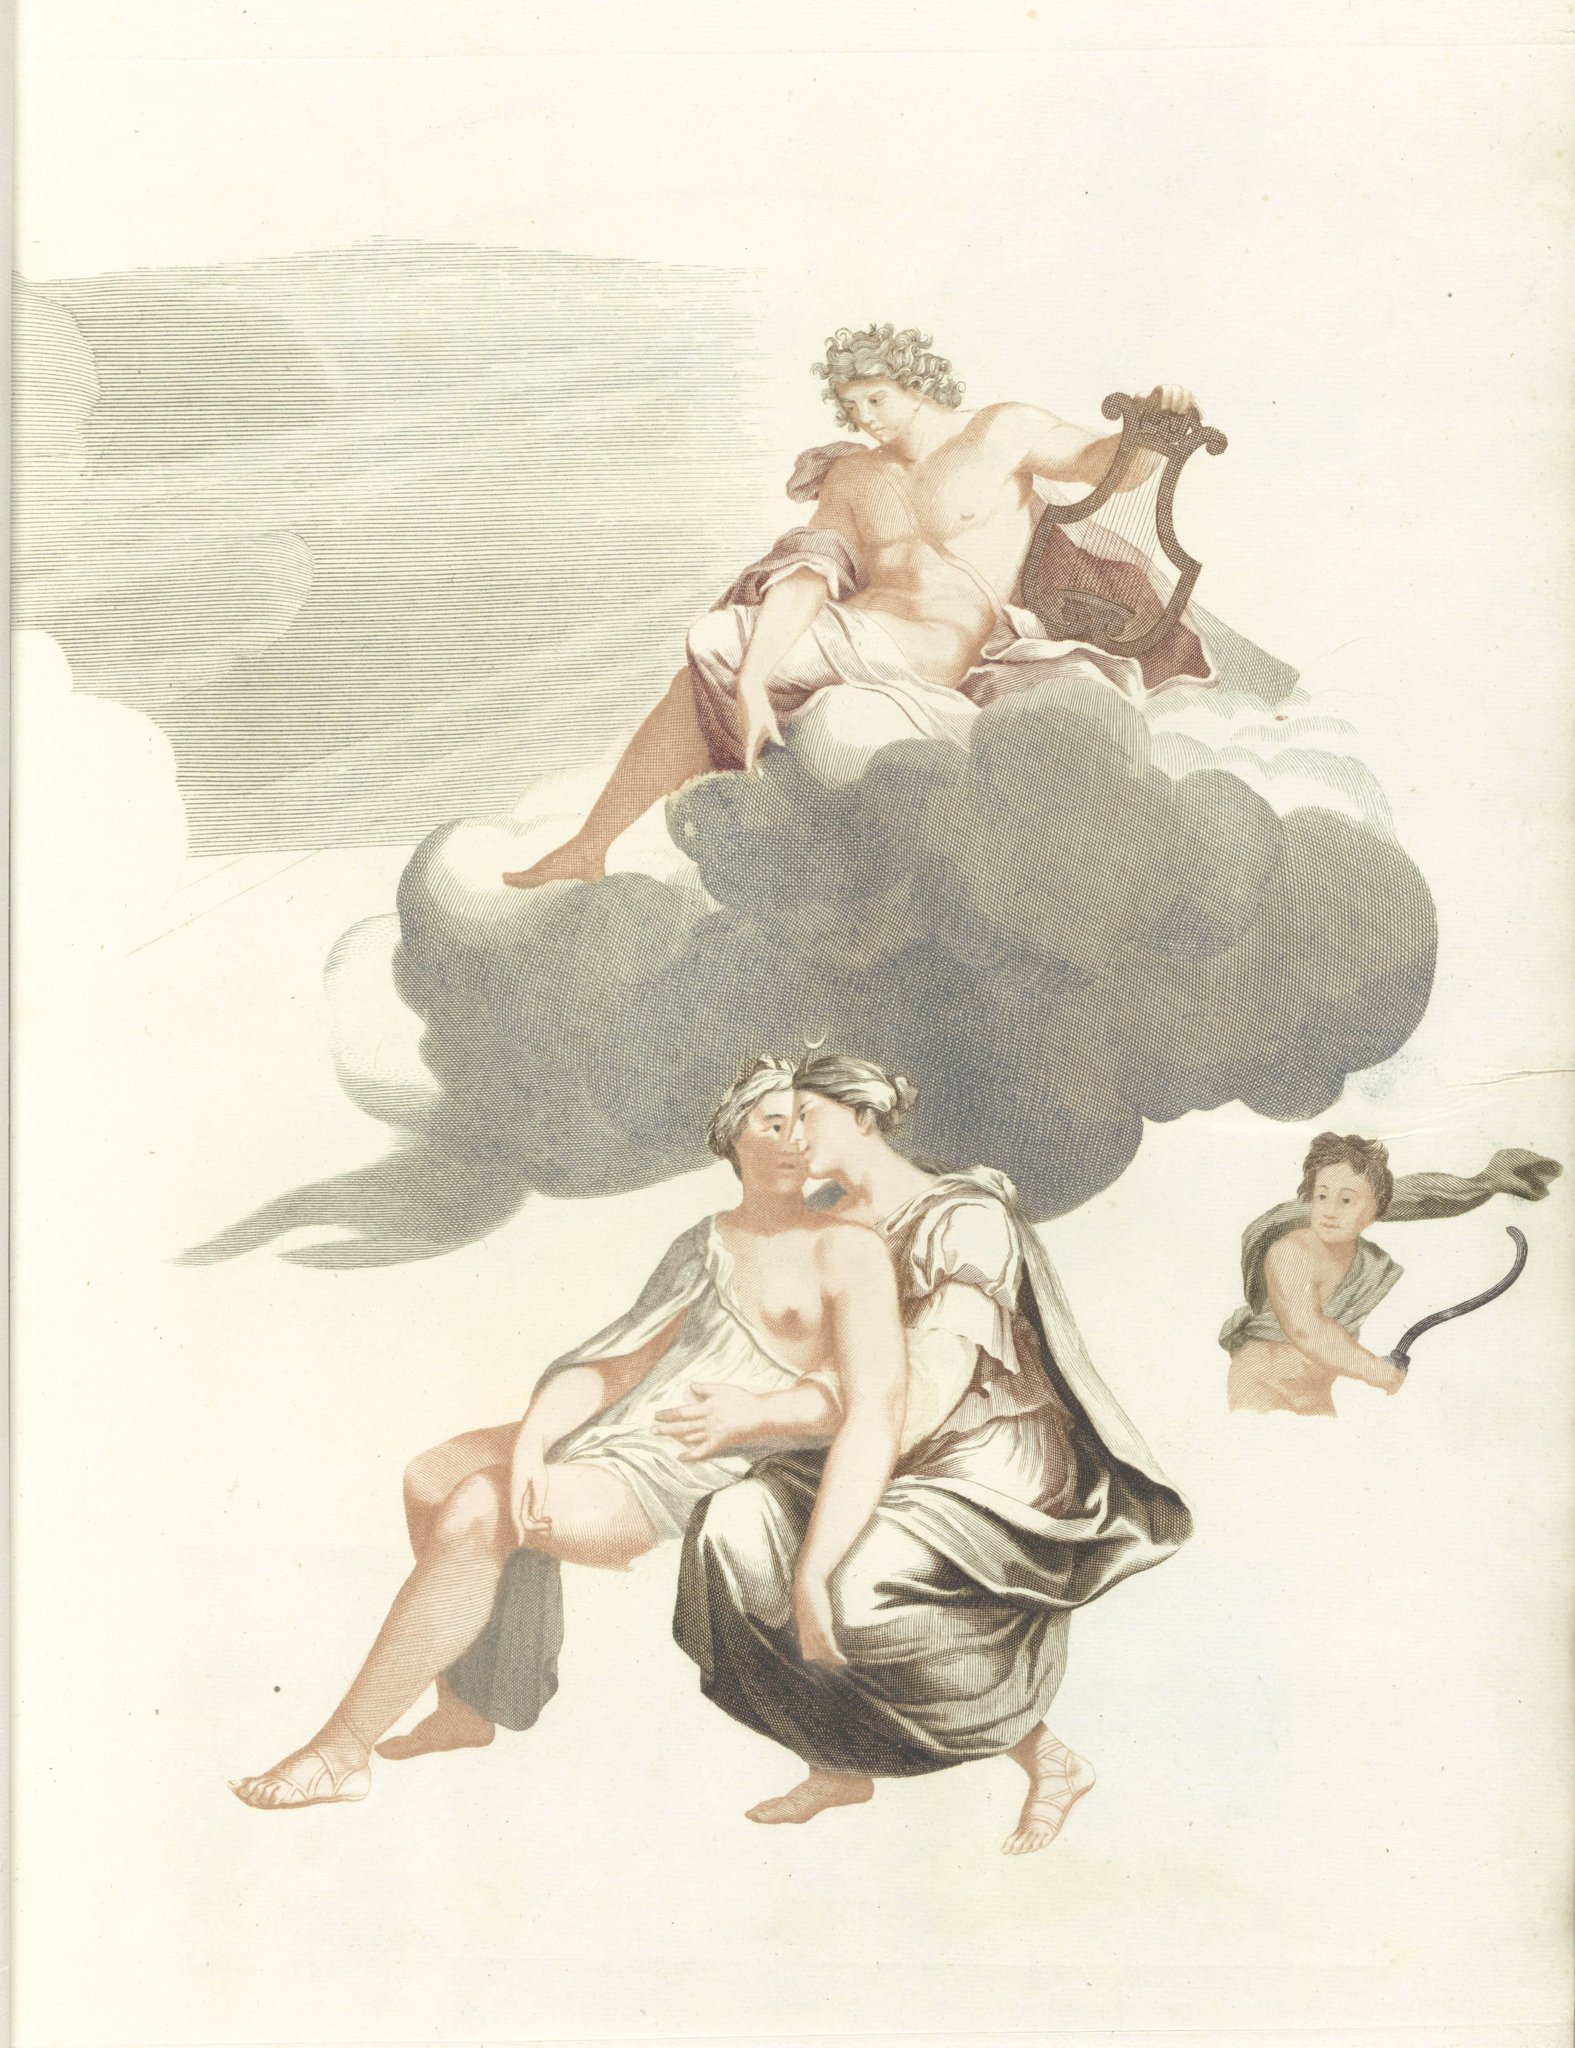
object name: print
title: Apollo op de wolken en Jupiter met Callisto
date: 1688-1698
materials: paper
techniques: printing, engraving, lithography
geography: netherlands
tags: attributes of apollo: lyre, jupiter, in the guise of diana, and callisto, cupid handling his weapons, (story of) apollo (phoebus), homosexual love - cc - homosexual love between women: lesbianism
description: Apollo zit met zijn lier op de wolken en kijkt neer op Jupiter en Callisto. Jupiter heeft zich vermomd als de maangodin Diana. Amor kijkt met een boog in zijn hand naar het liefdespaar. Deze prent maakt deel uit van een album.